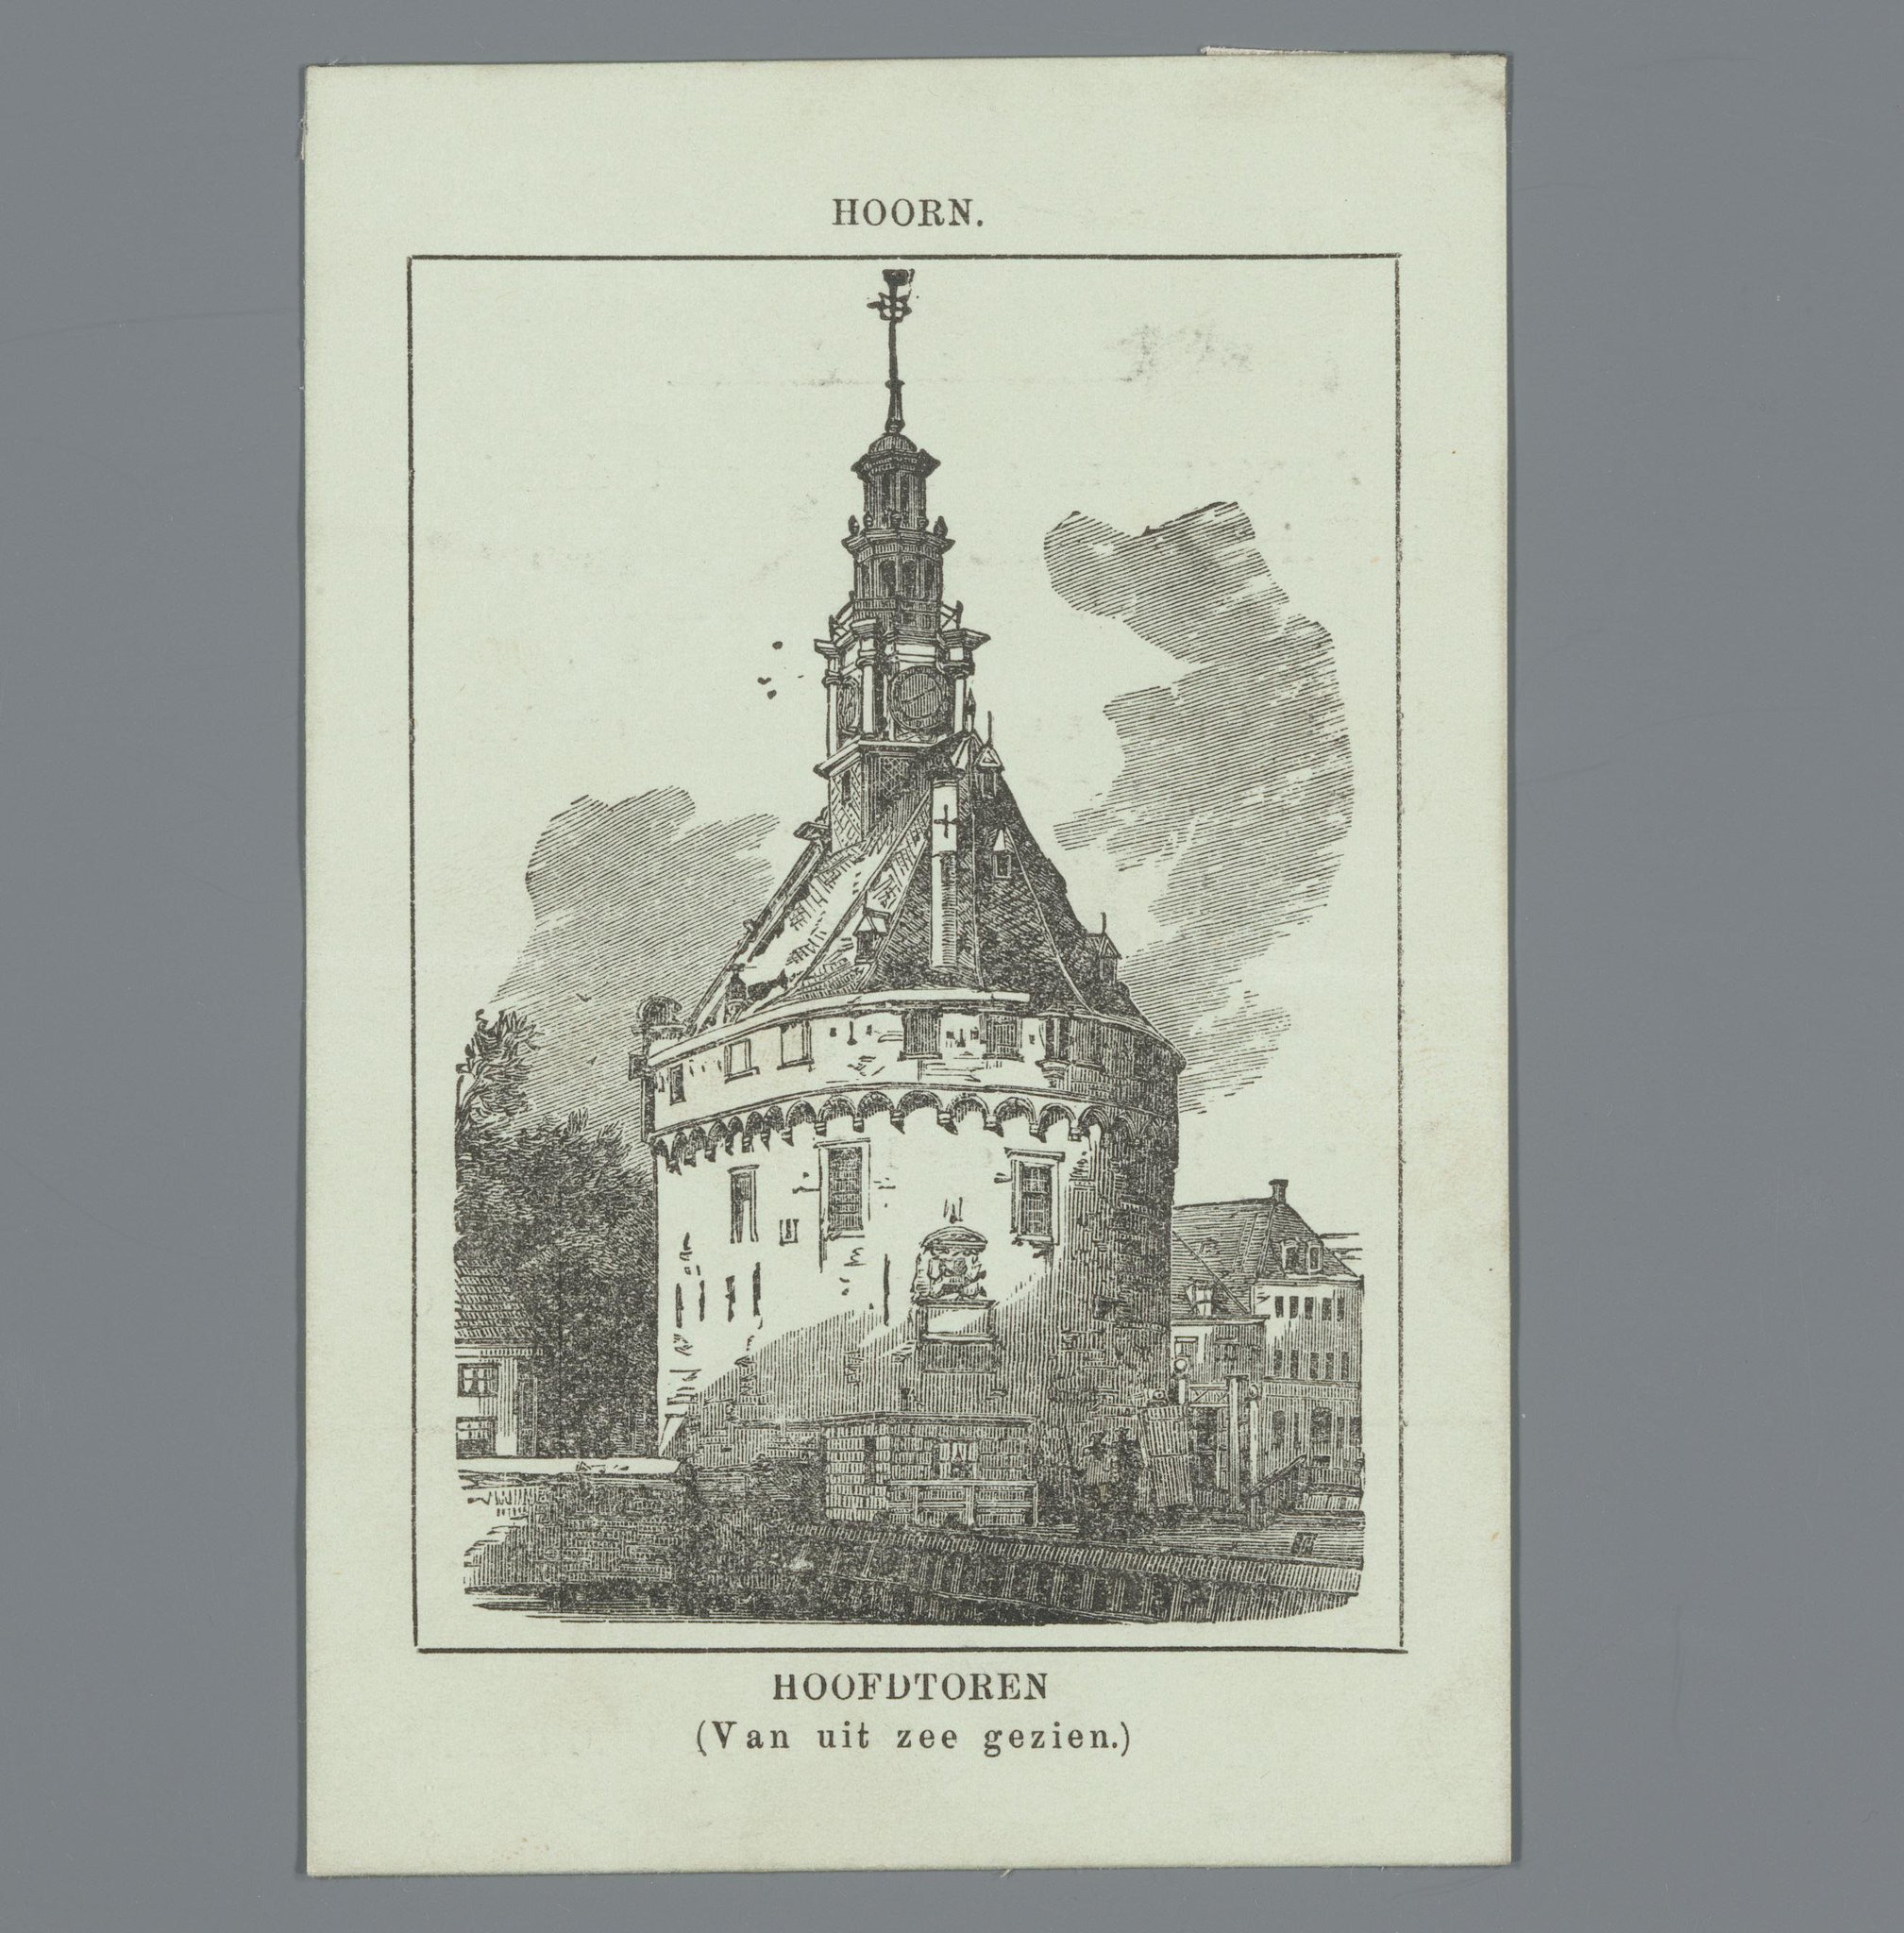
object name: print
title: Gezicht op de Hoofdtoren in Hoorn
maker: Anonymous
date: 1800-1899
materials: paper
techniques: letterpress printing, engraving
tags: towers ~ fortified city, hoorn (north holland)